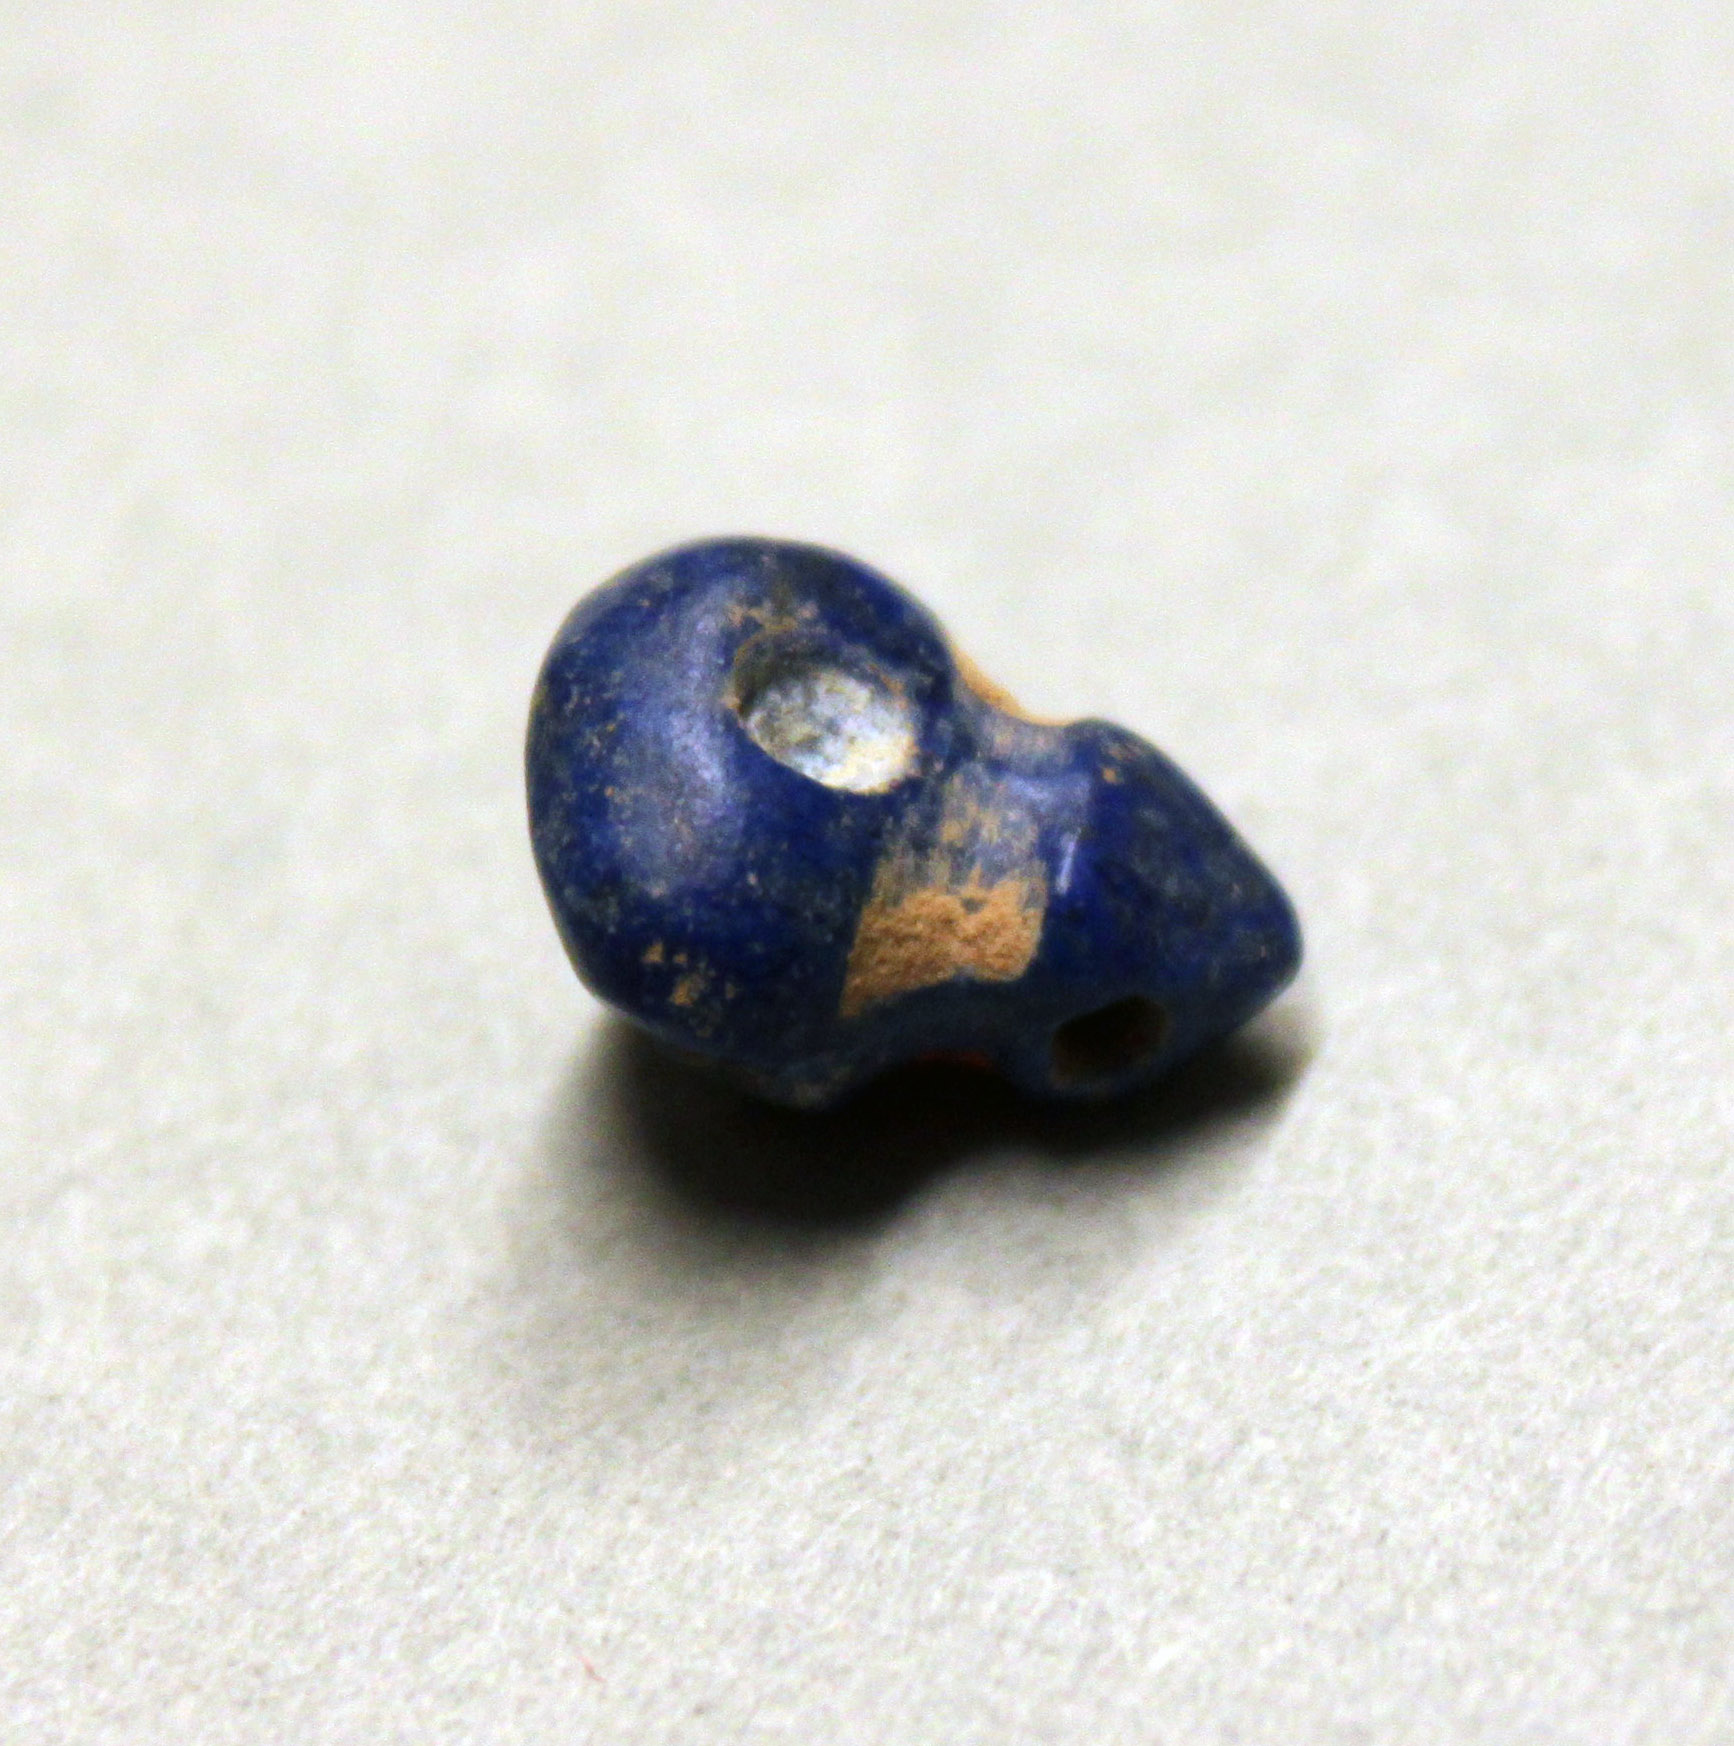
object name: bead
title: Beads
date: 801-1200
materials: lapis lazuli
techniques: cutting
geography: iran